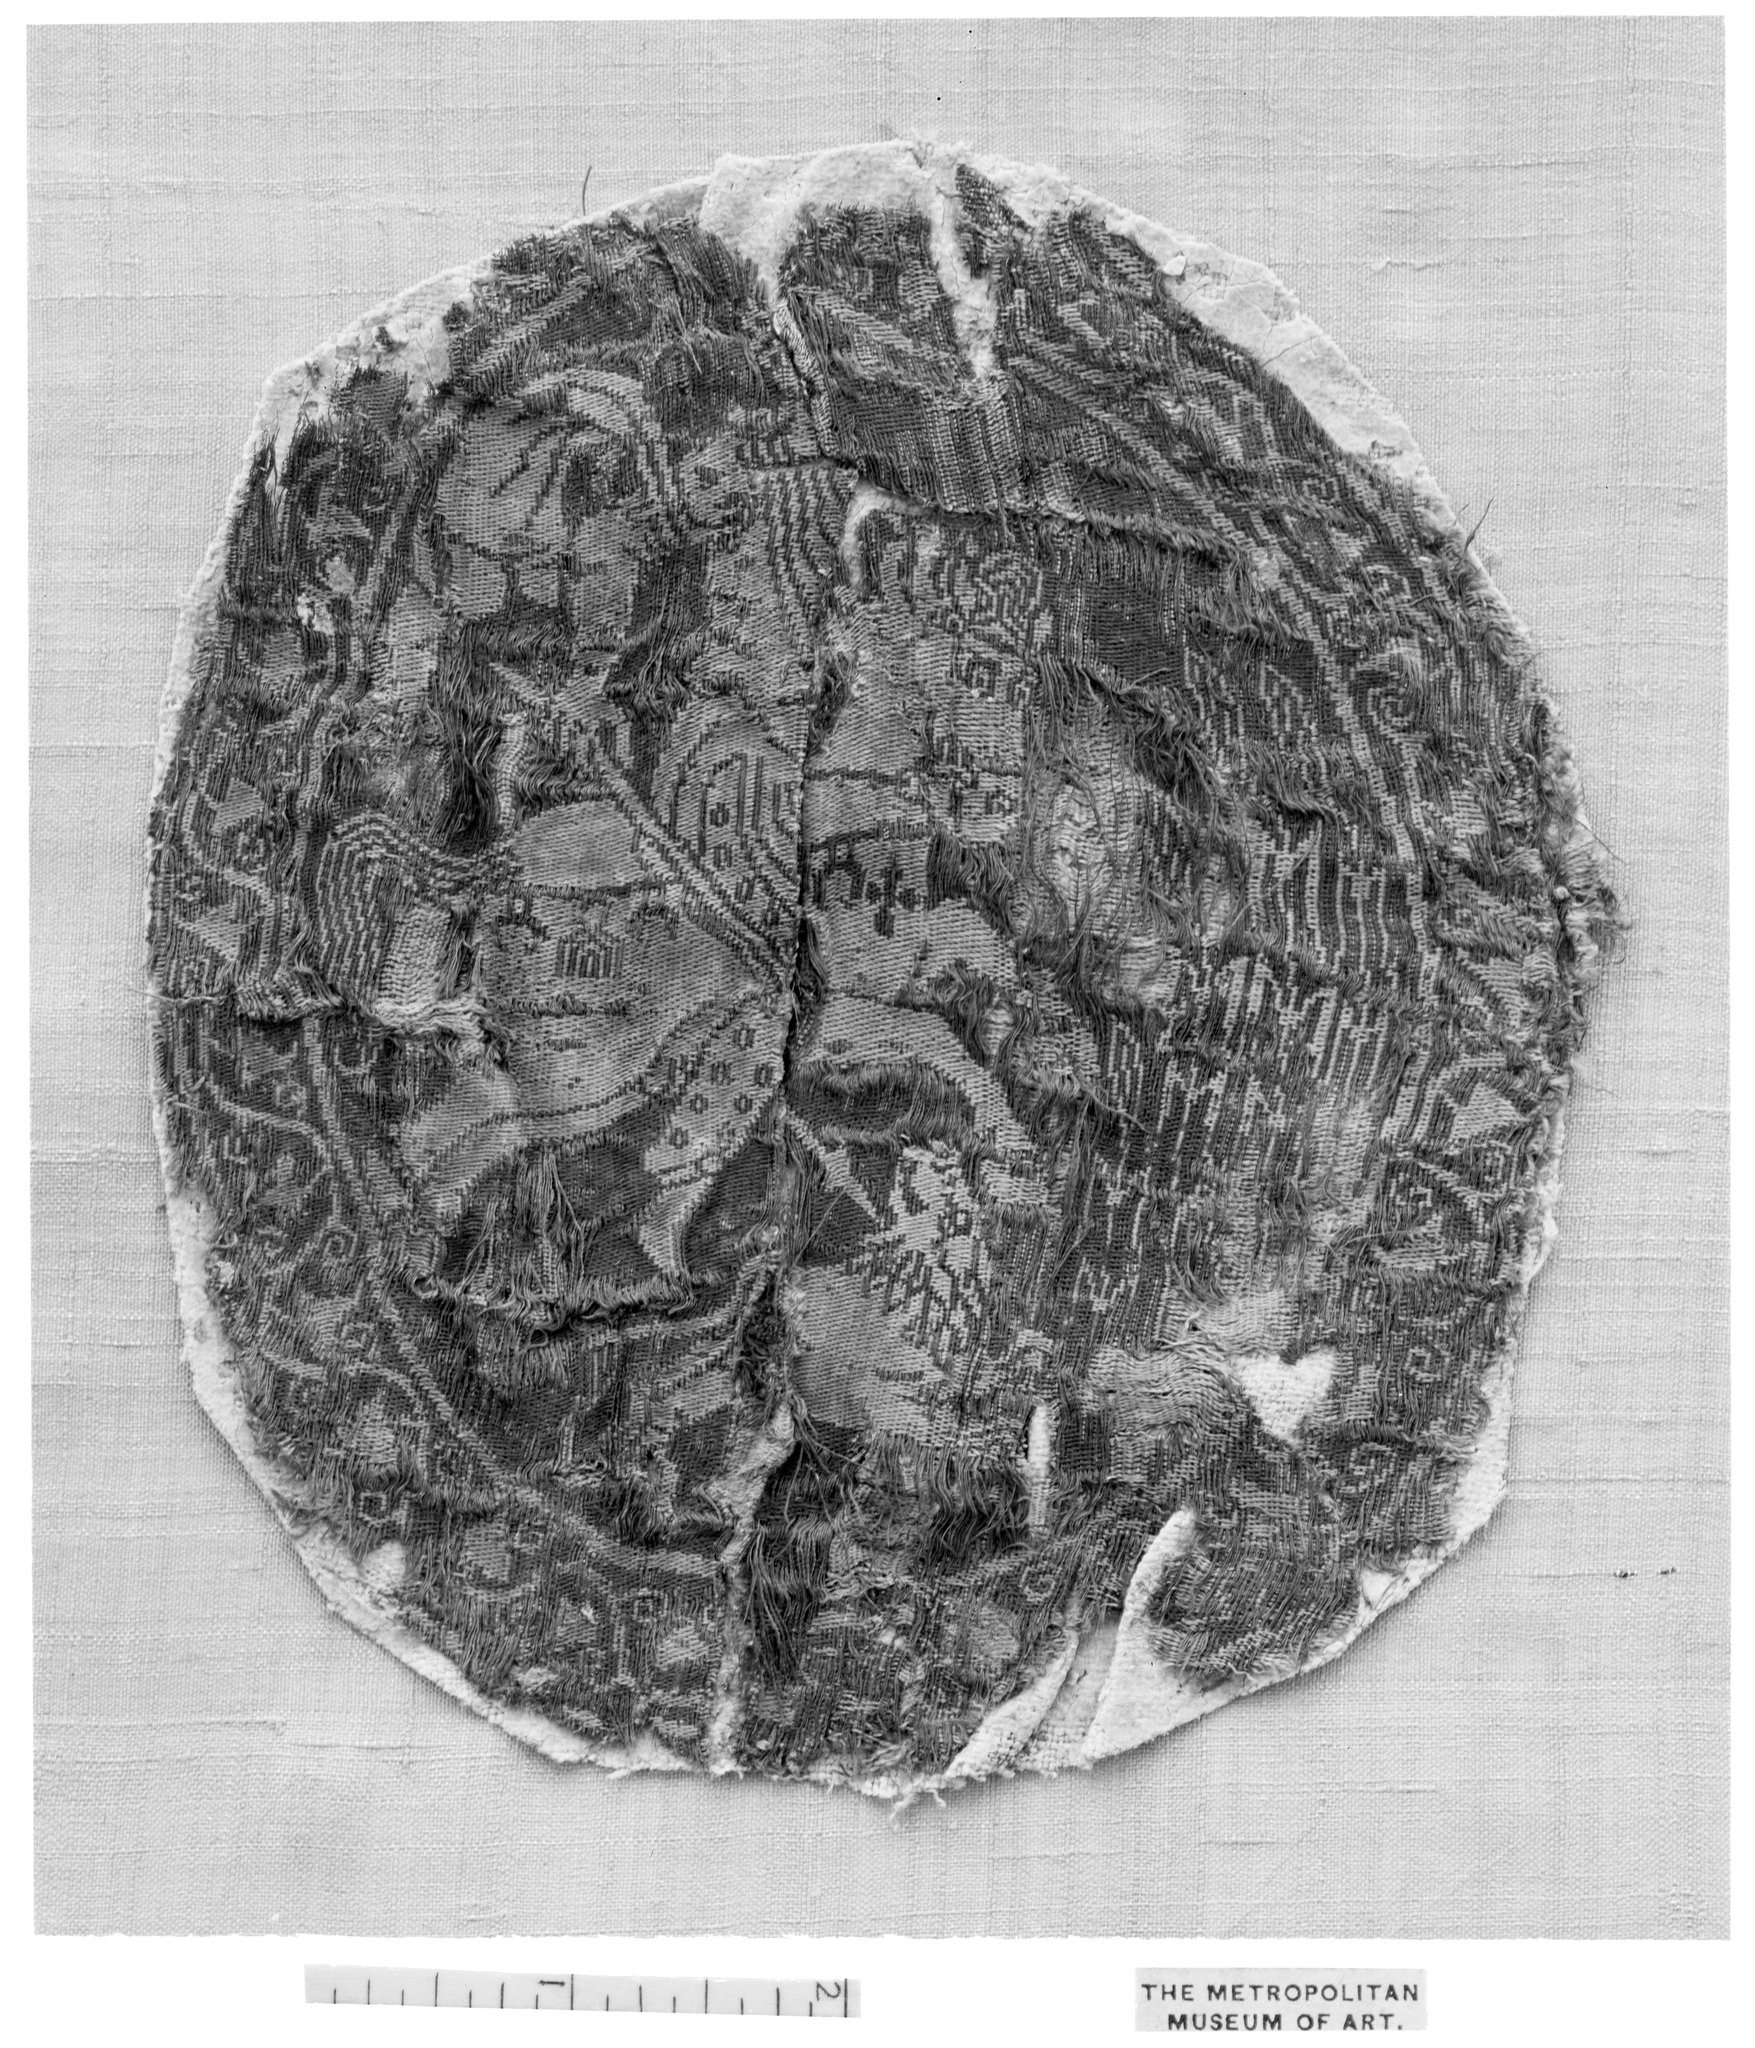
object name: textile fragment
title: Roundel with Mounted Horseman Spearing a Lion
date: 601-800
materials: silk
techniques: weave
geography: egypt